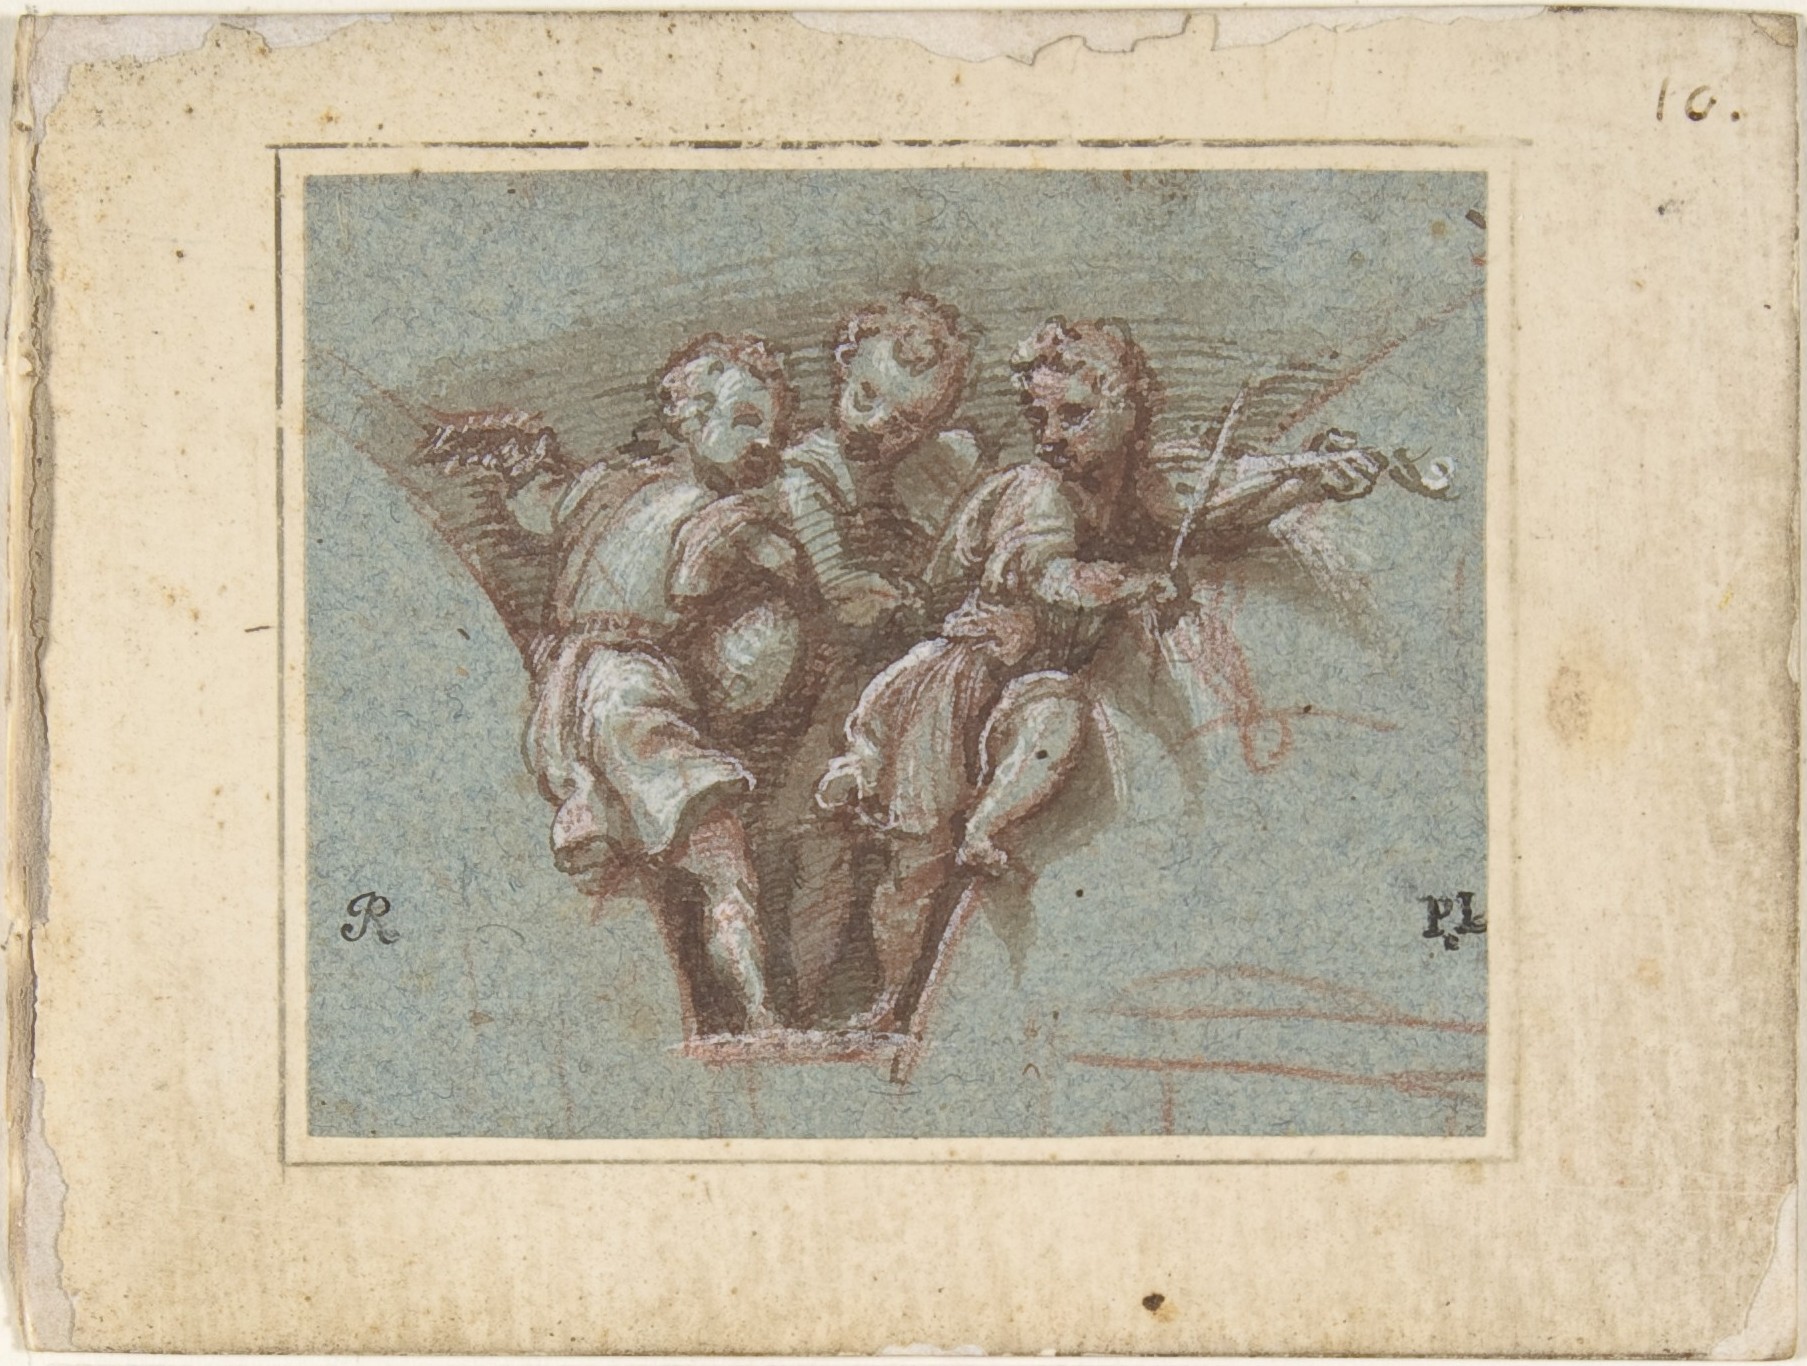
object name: drawing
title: Design for a Pendentive: Youthful Musicians with Stringed Instruments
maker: pomponio amalteo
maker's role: artist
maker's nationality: italian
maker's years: 1505-1588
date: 1505-1588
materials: chalk, ink, paper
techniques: brush, highlighting, pen, wash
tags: musical instruments,musicians